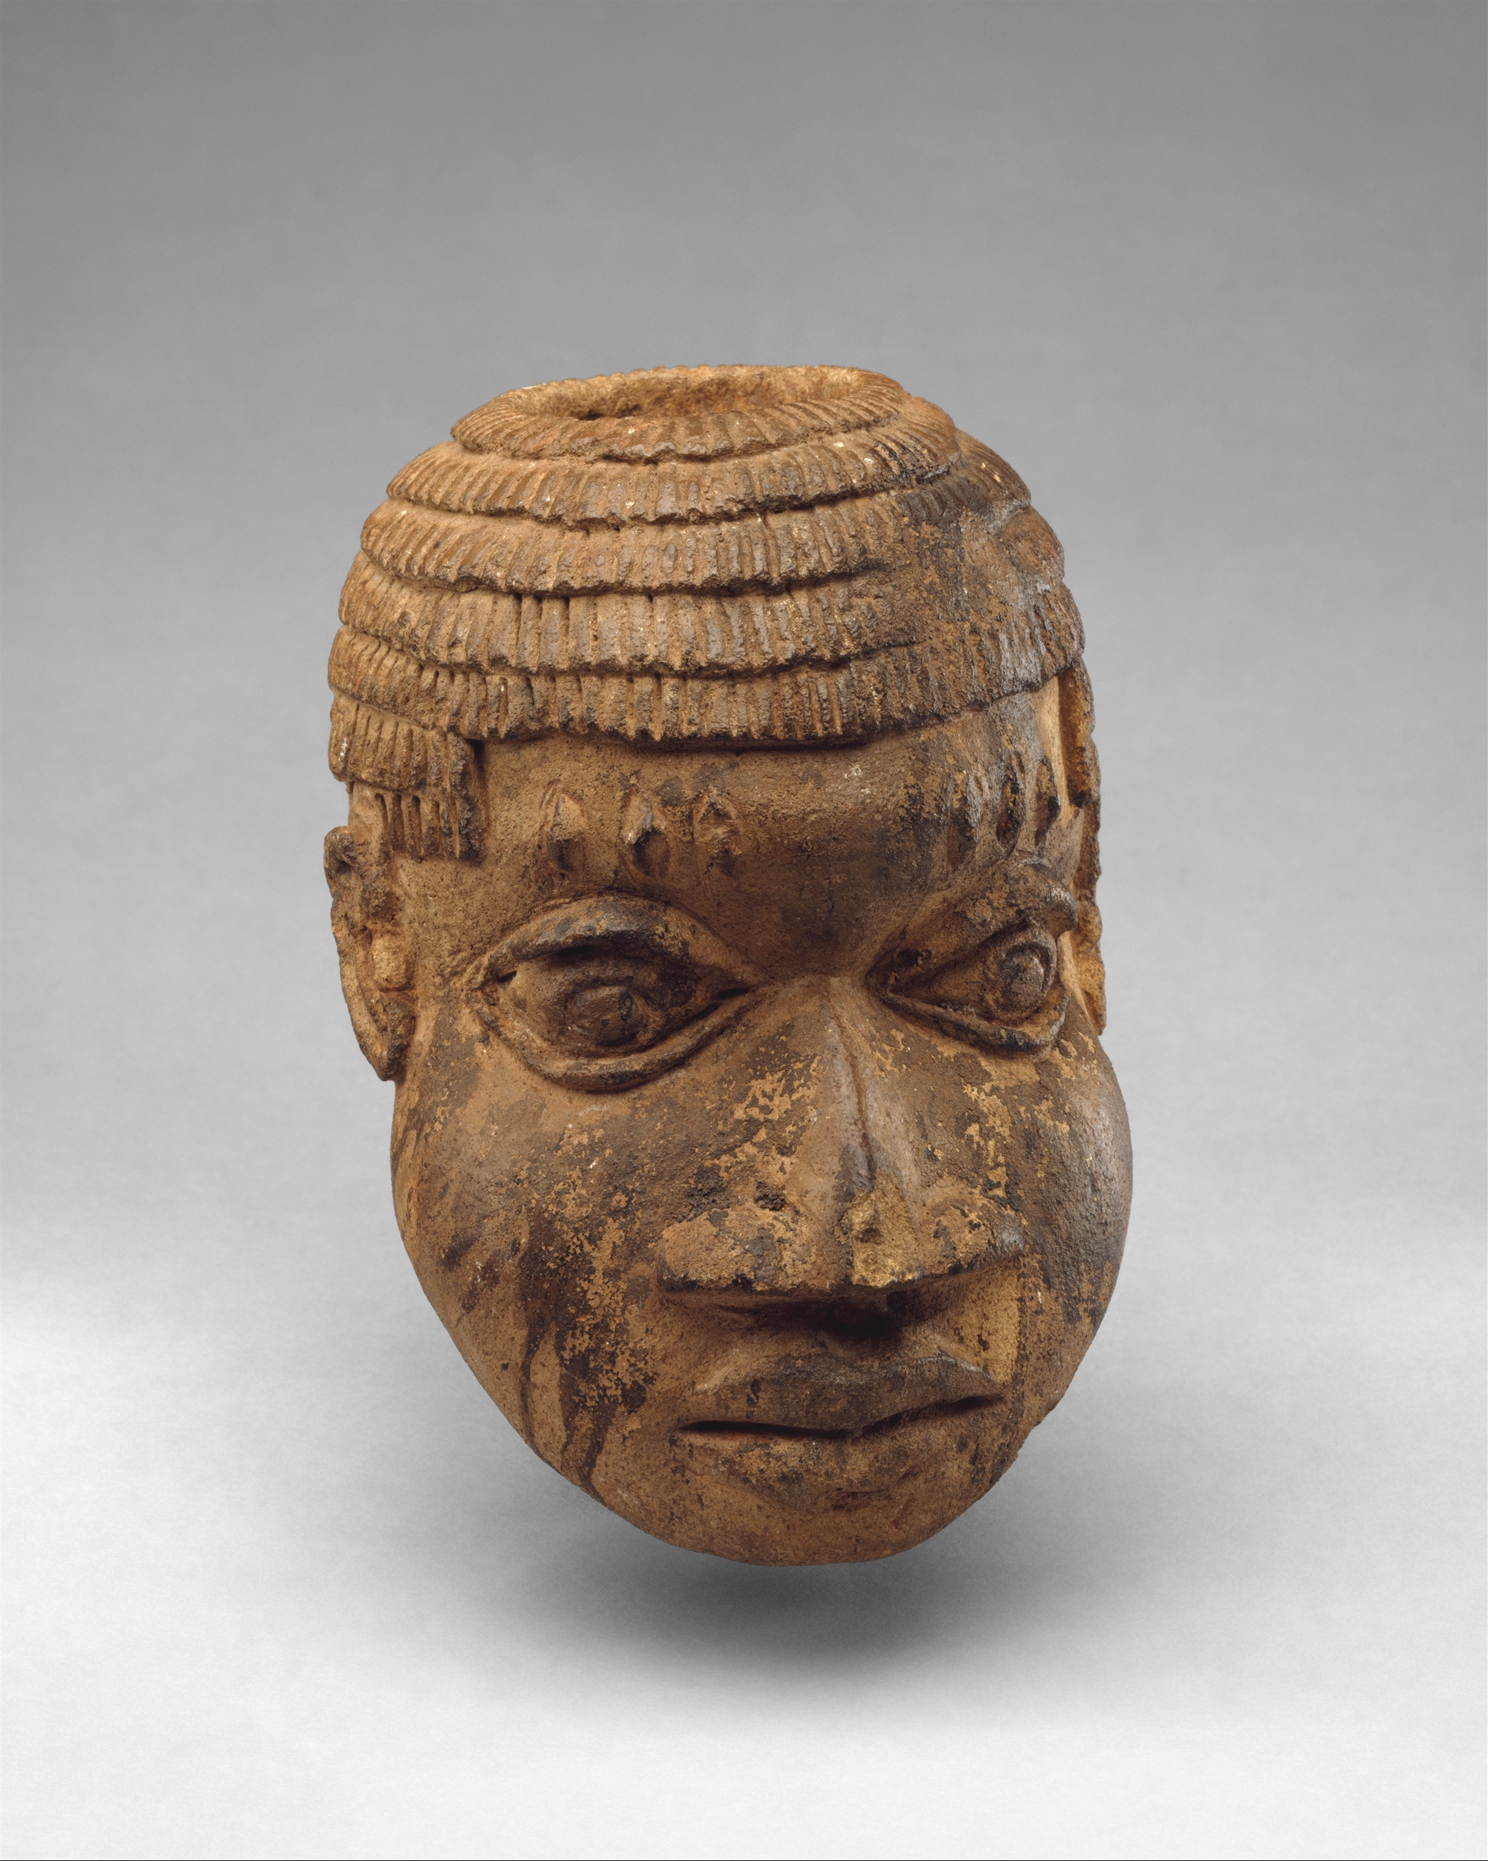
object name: head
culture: edo period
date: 1501-1700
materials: terracotta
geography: nigeria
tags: heads